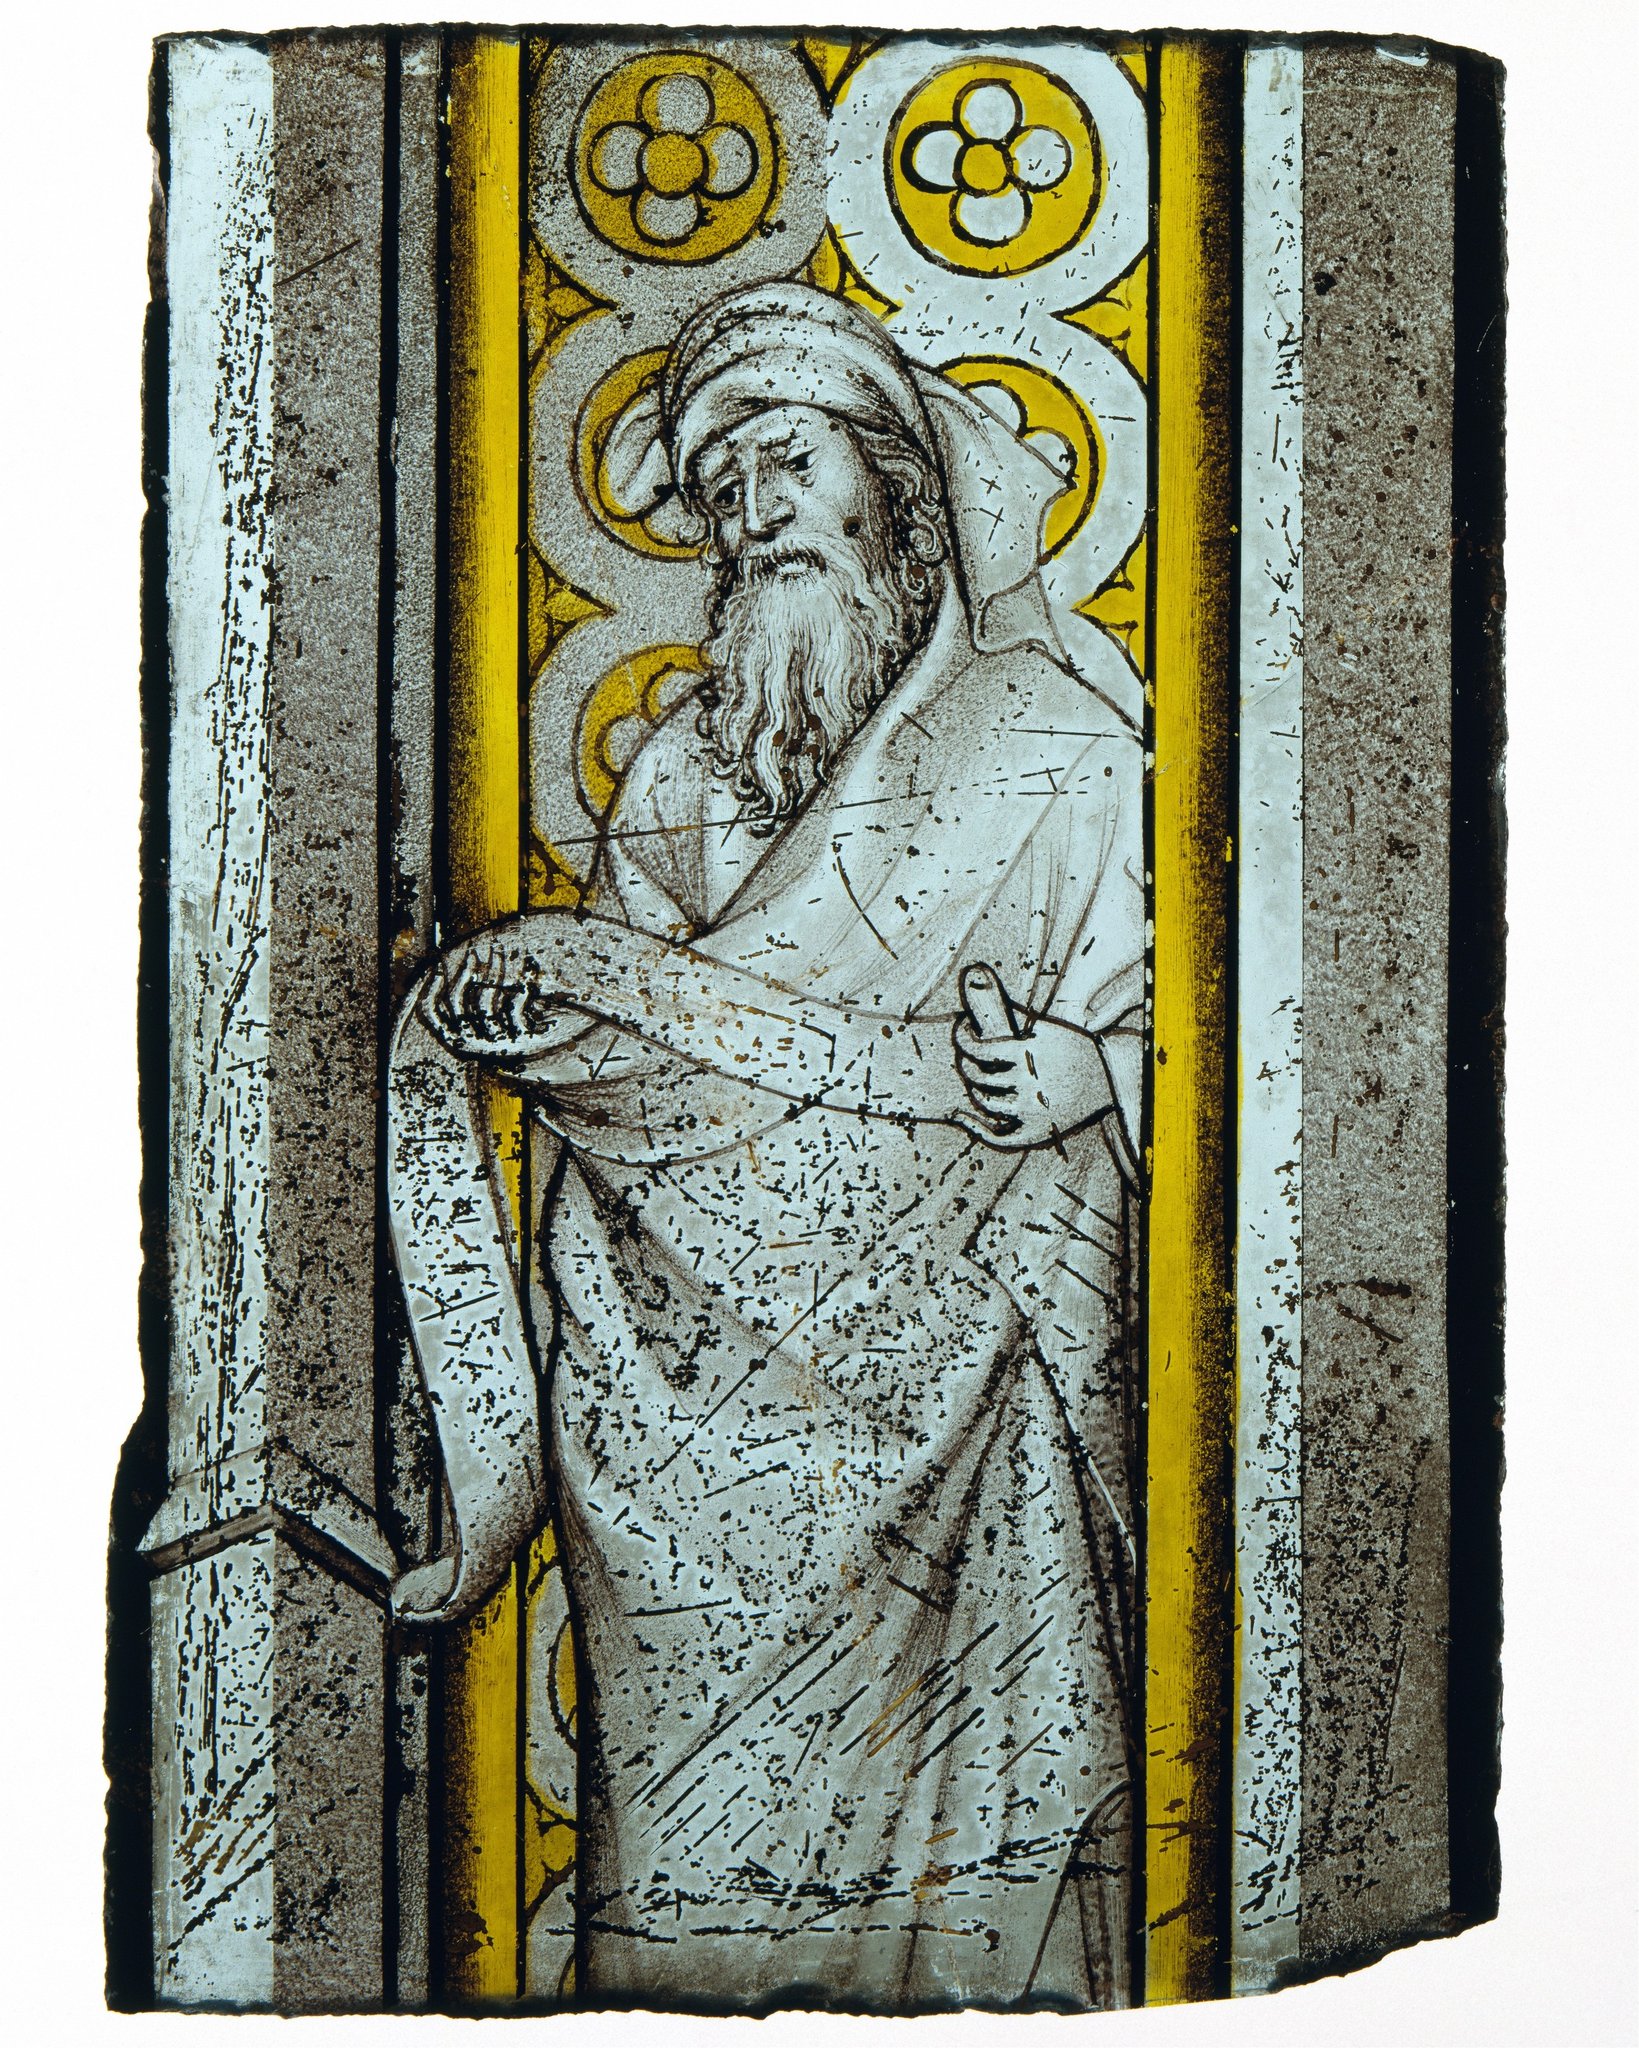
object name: panel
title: Prophet from a Throne of Solomon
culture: french or south netherlandish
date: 1390-1410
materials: glass, paint, pigment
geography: bourges or burgundy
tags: men